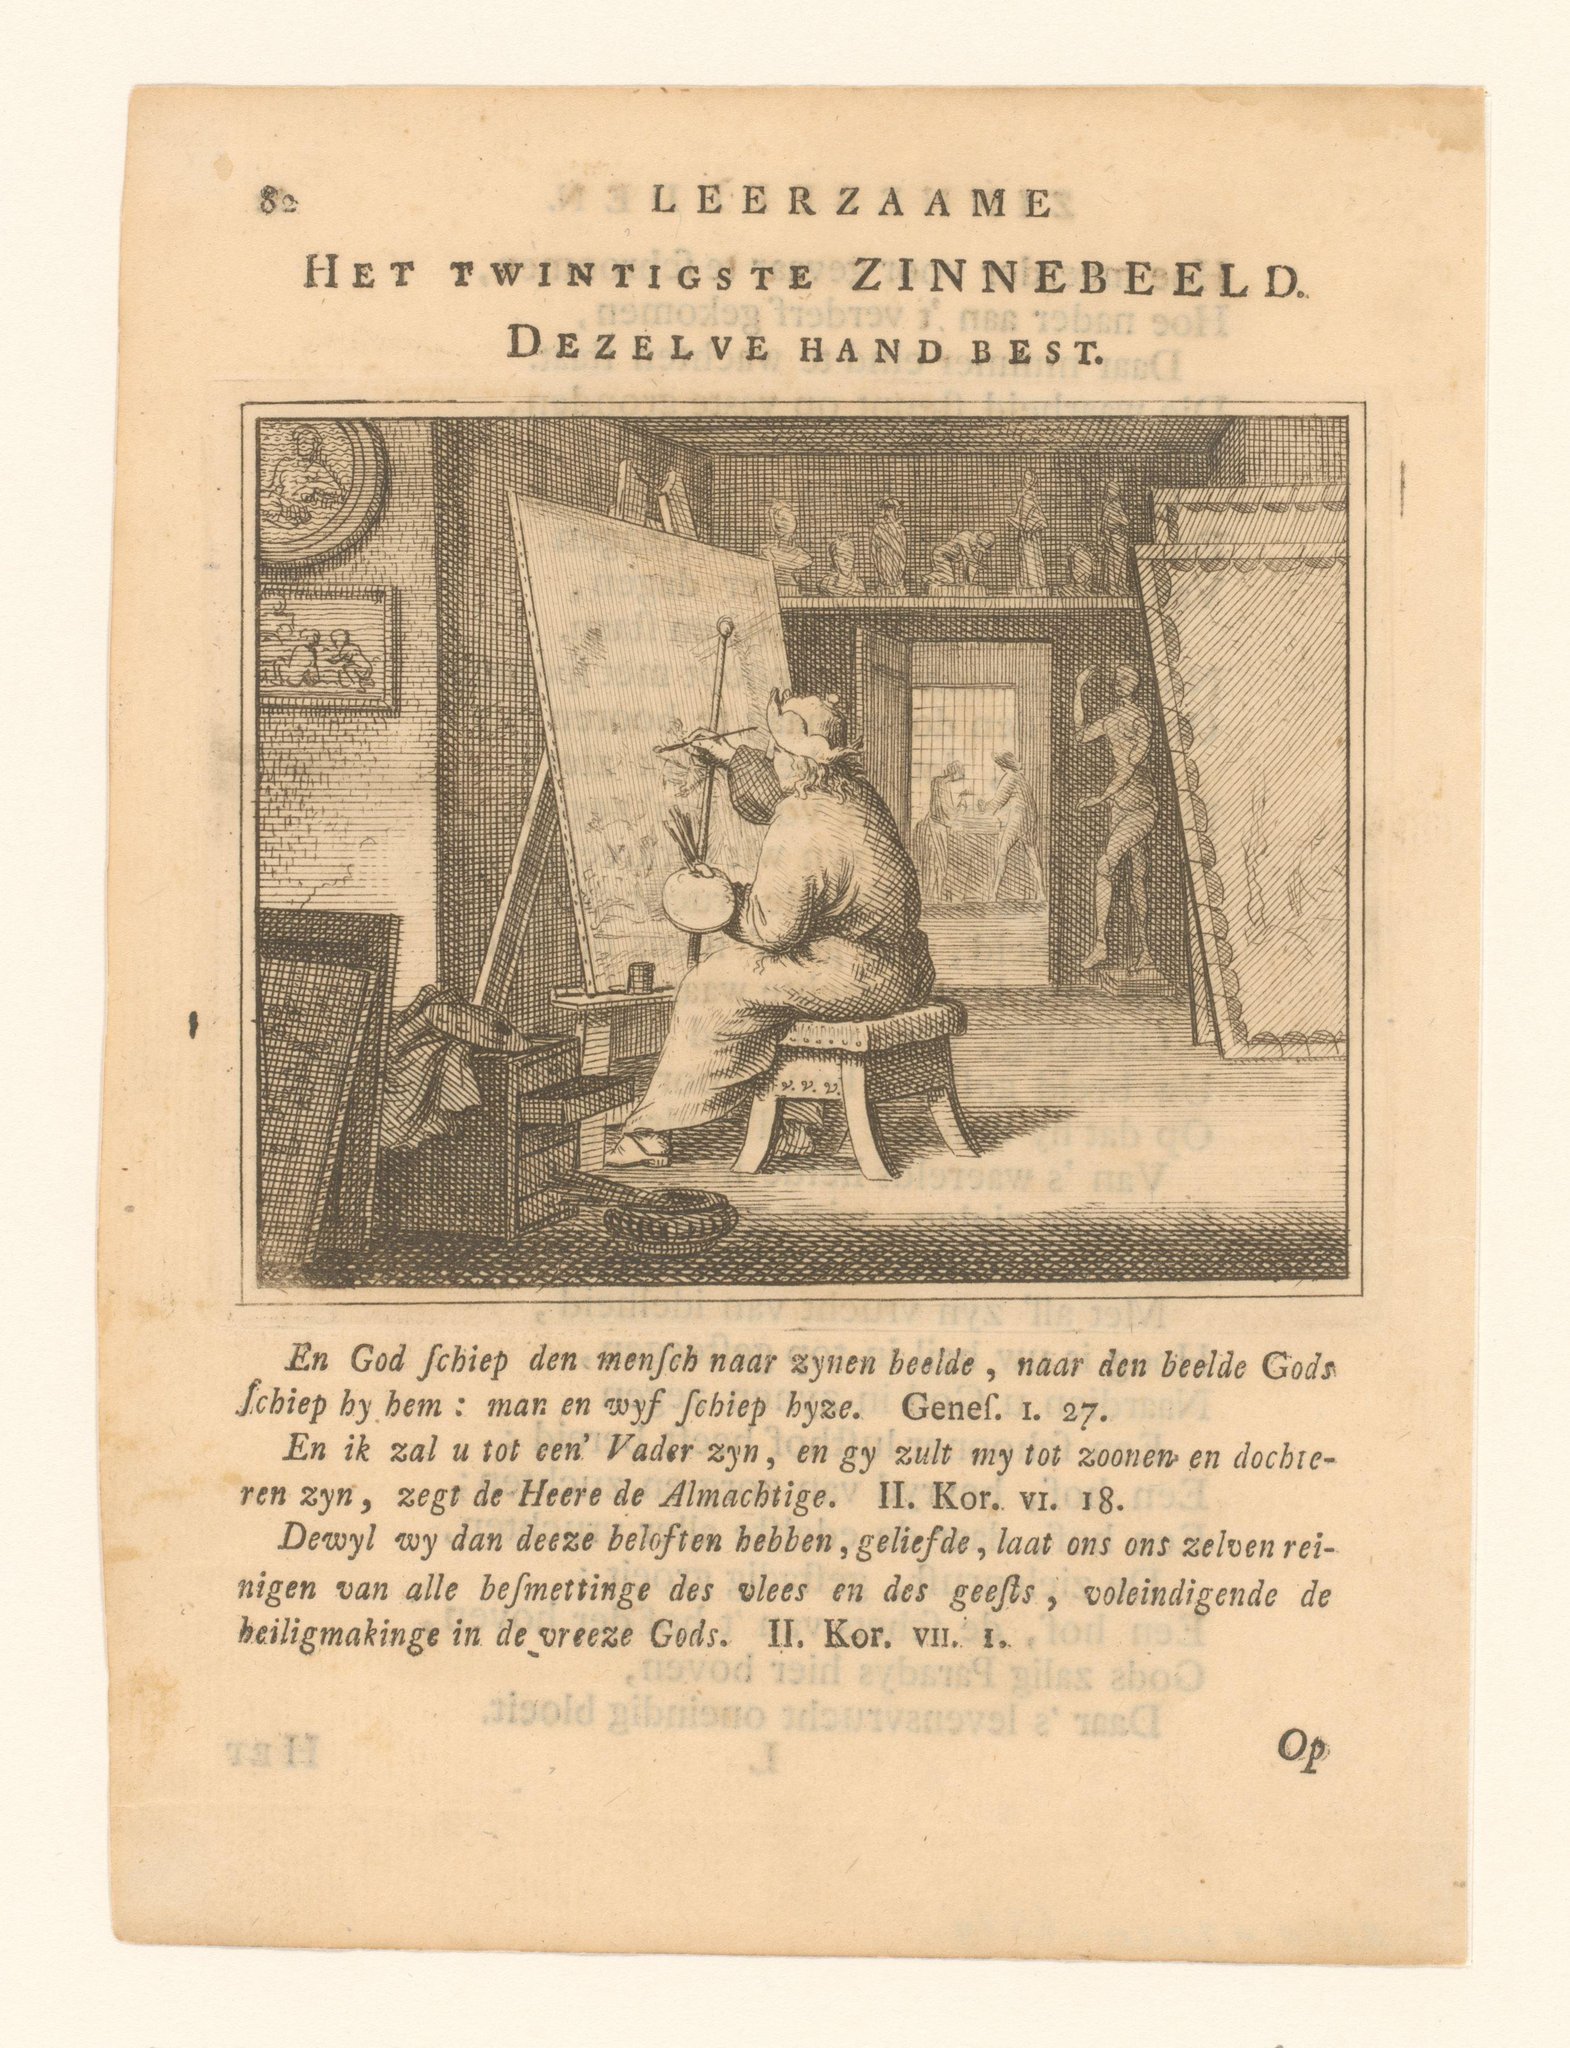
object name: book illustration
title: Schilder aan het werk in zijn atelier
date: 1758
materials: paper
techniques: etching, letterpress printing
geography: northern netherlands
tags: painter at work, in his studio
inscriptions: collector's mark: Lugt 2228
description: Bladzijde uit: Spinniker, Adriaan. Vervolg der leerzaame zinnebeelden, spiegel der boetvaardigheid en genade (...). Haarlem: Jan Bosch, 1758, p. 82.